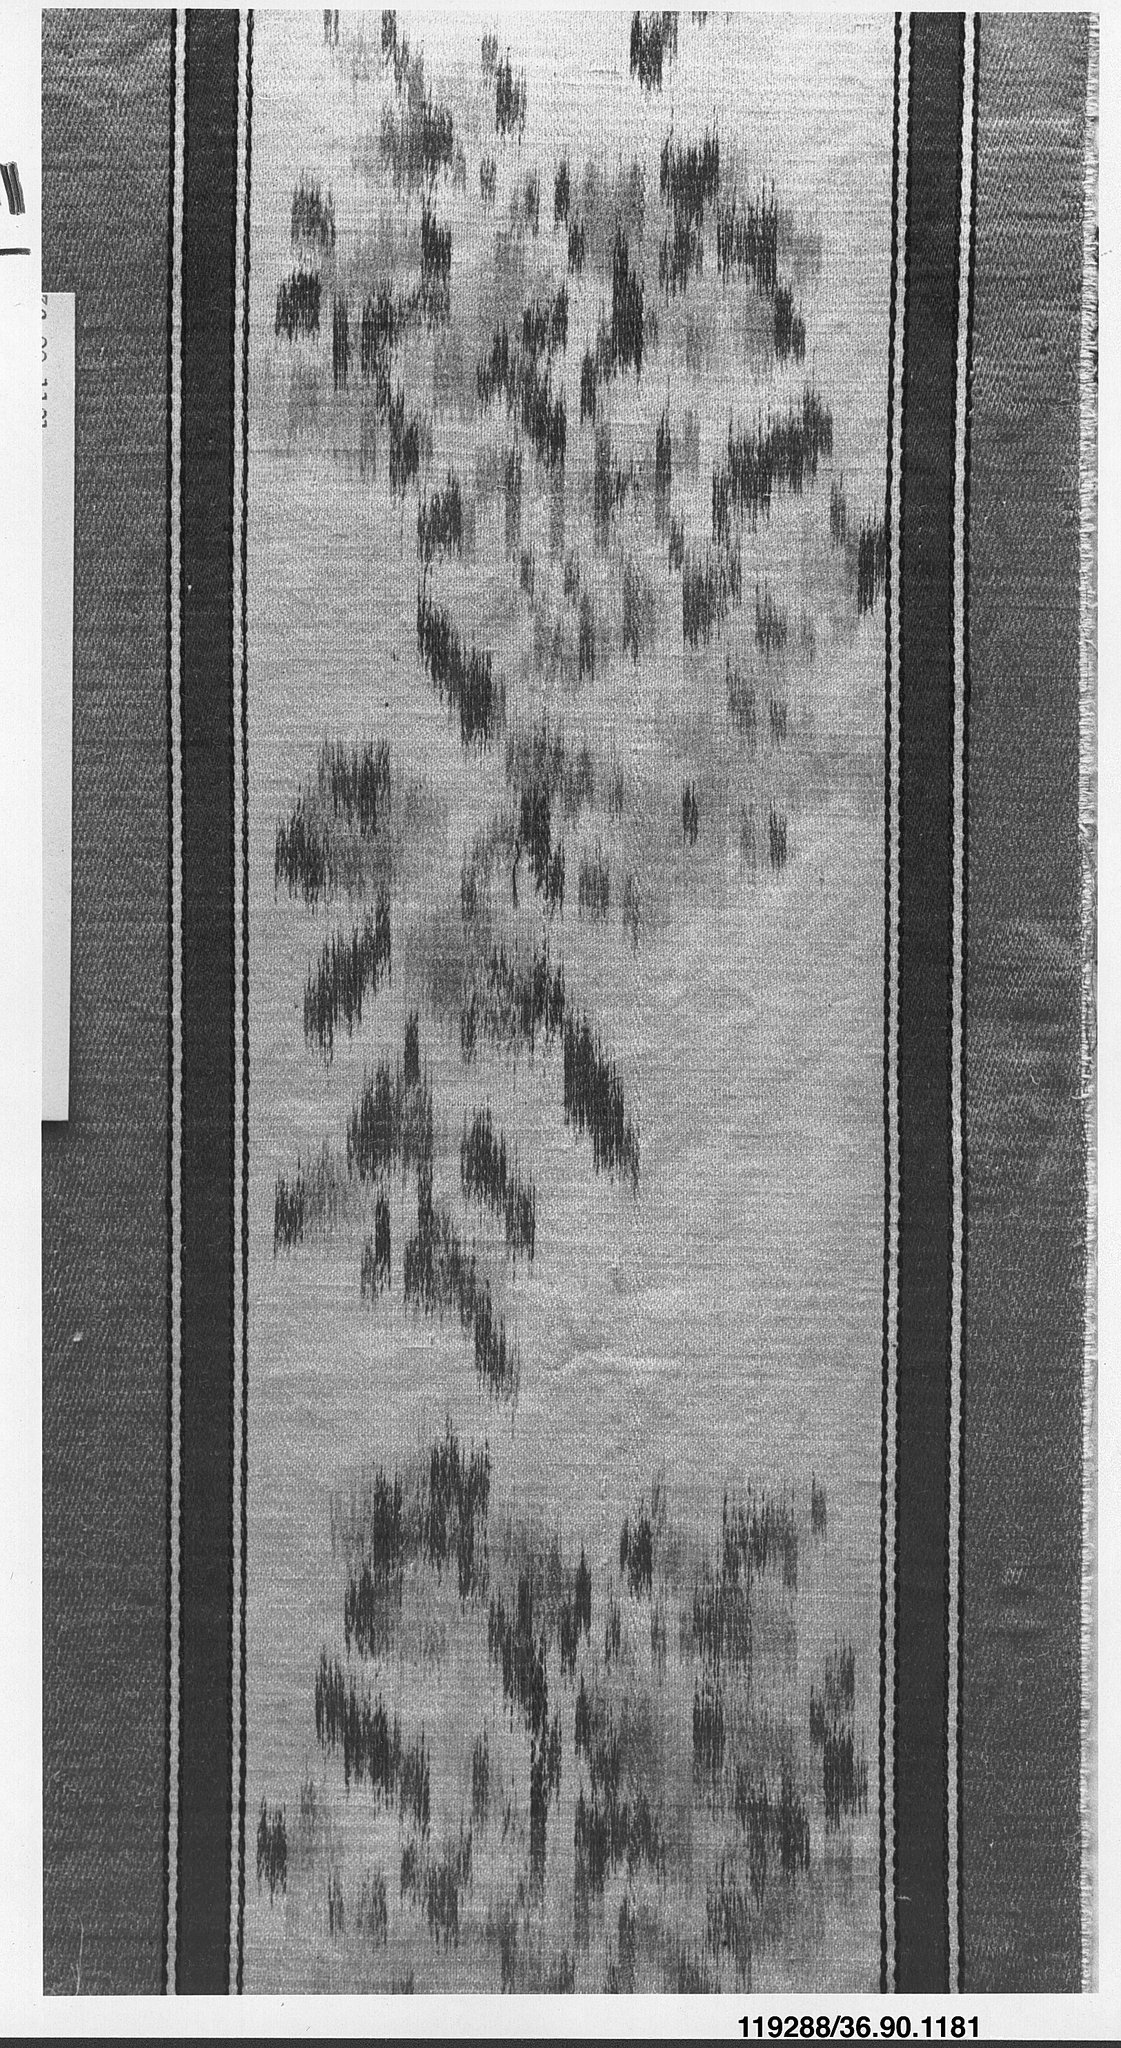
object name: piece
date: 1701-1800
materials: silk